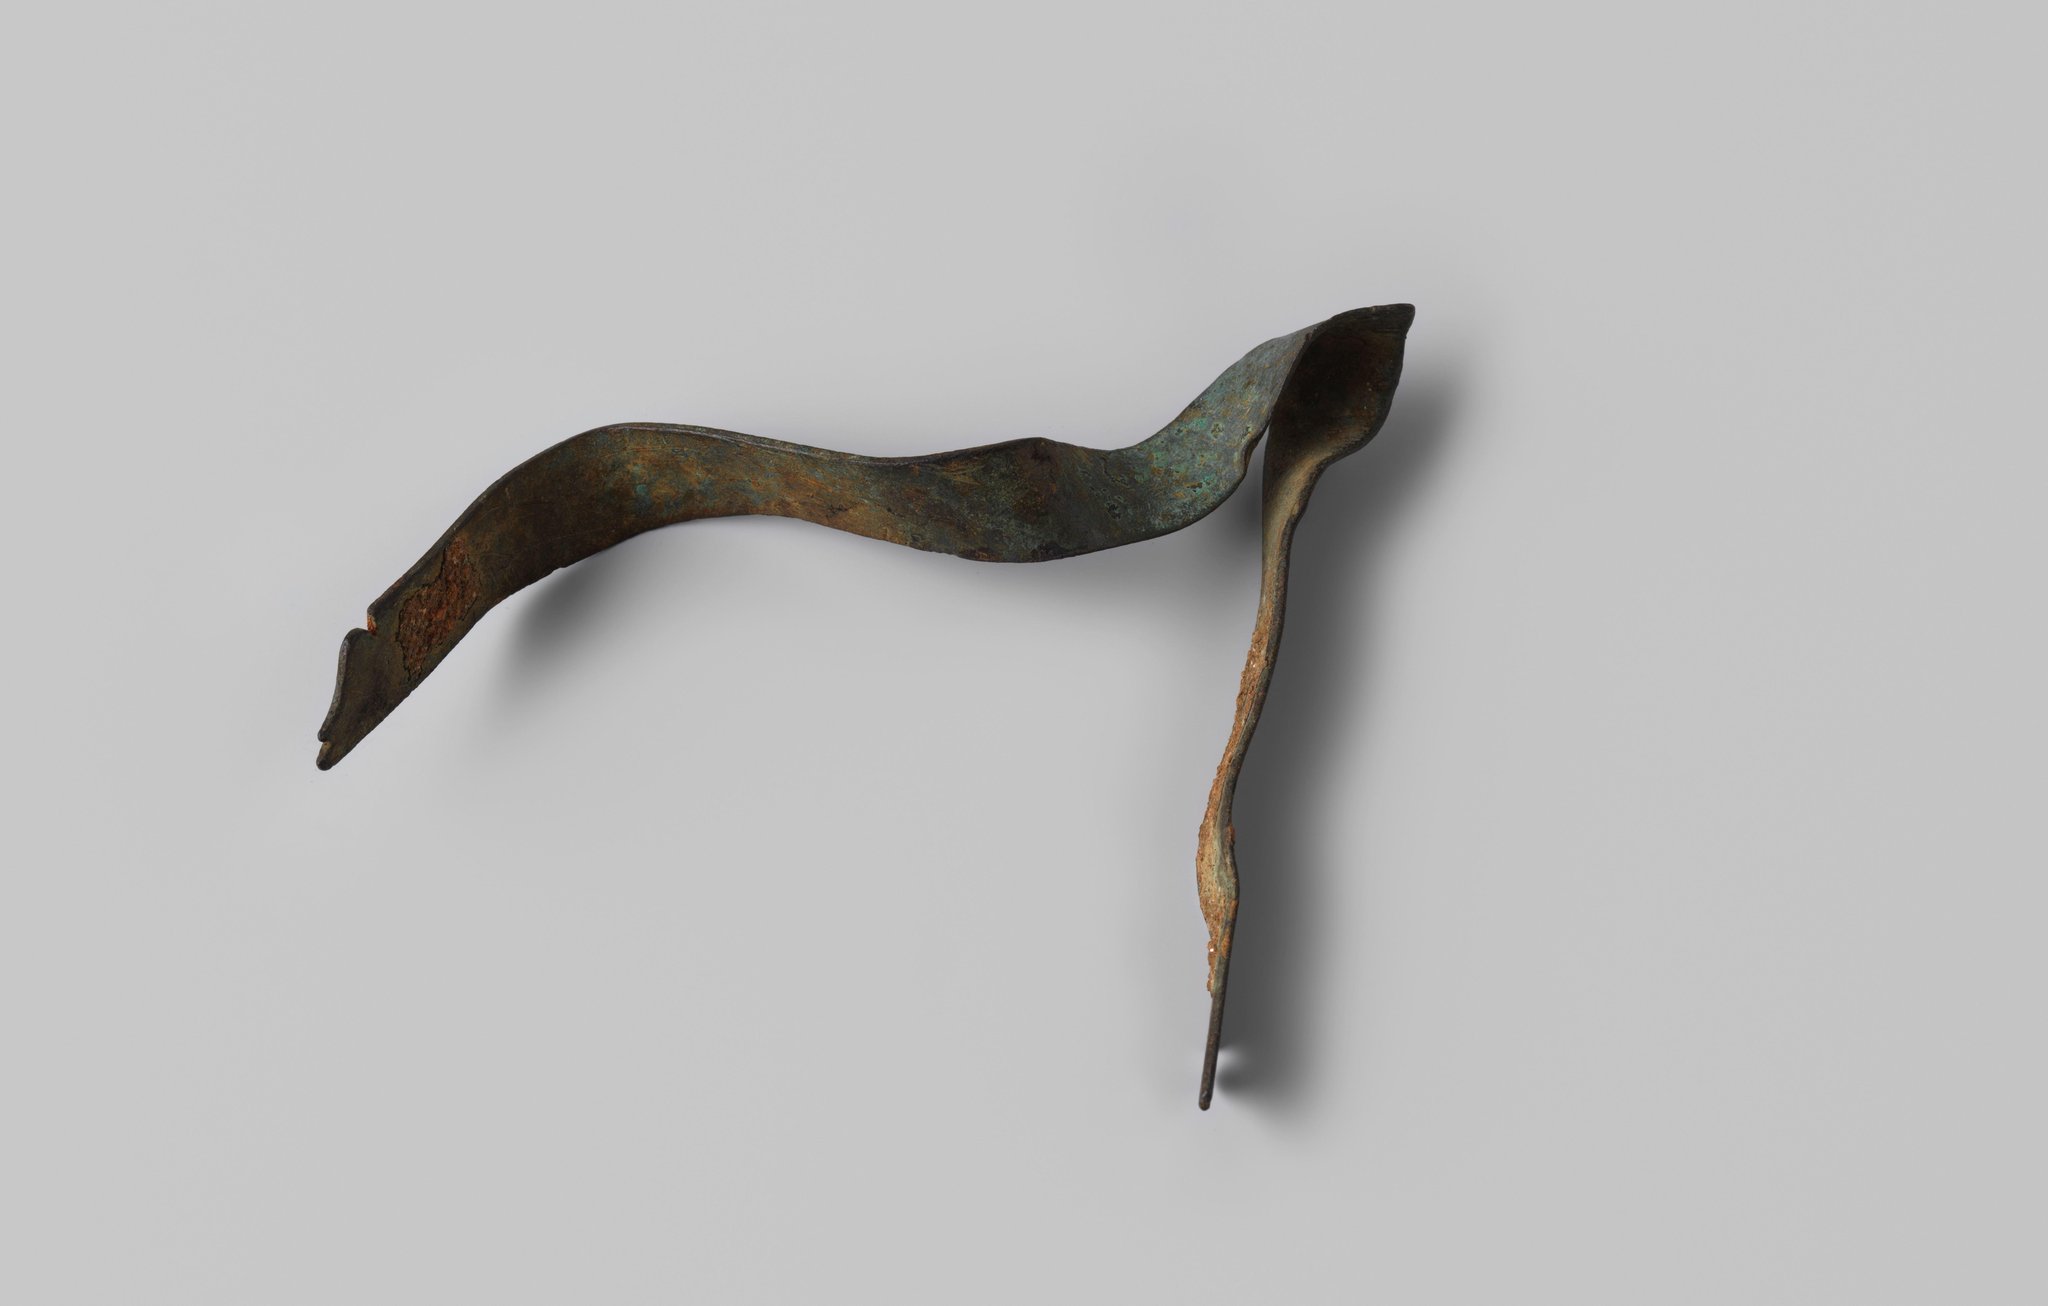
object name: fragment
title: Fragment van koper uit het wrak van de Oost-Indiëvaarder Hollandia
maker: Anonymous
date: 1700-1743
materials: copper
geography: netherlands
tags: verenigde oostindische compagnie, hollandia (schip), annet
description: Varied parts or fragments, strips and strip-shaped fragments; fragm.